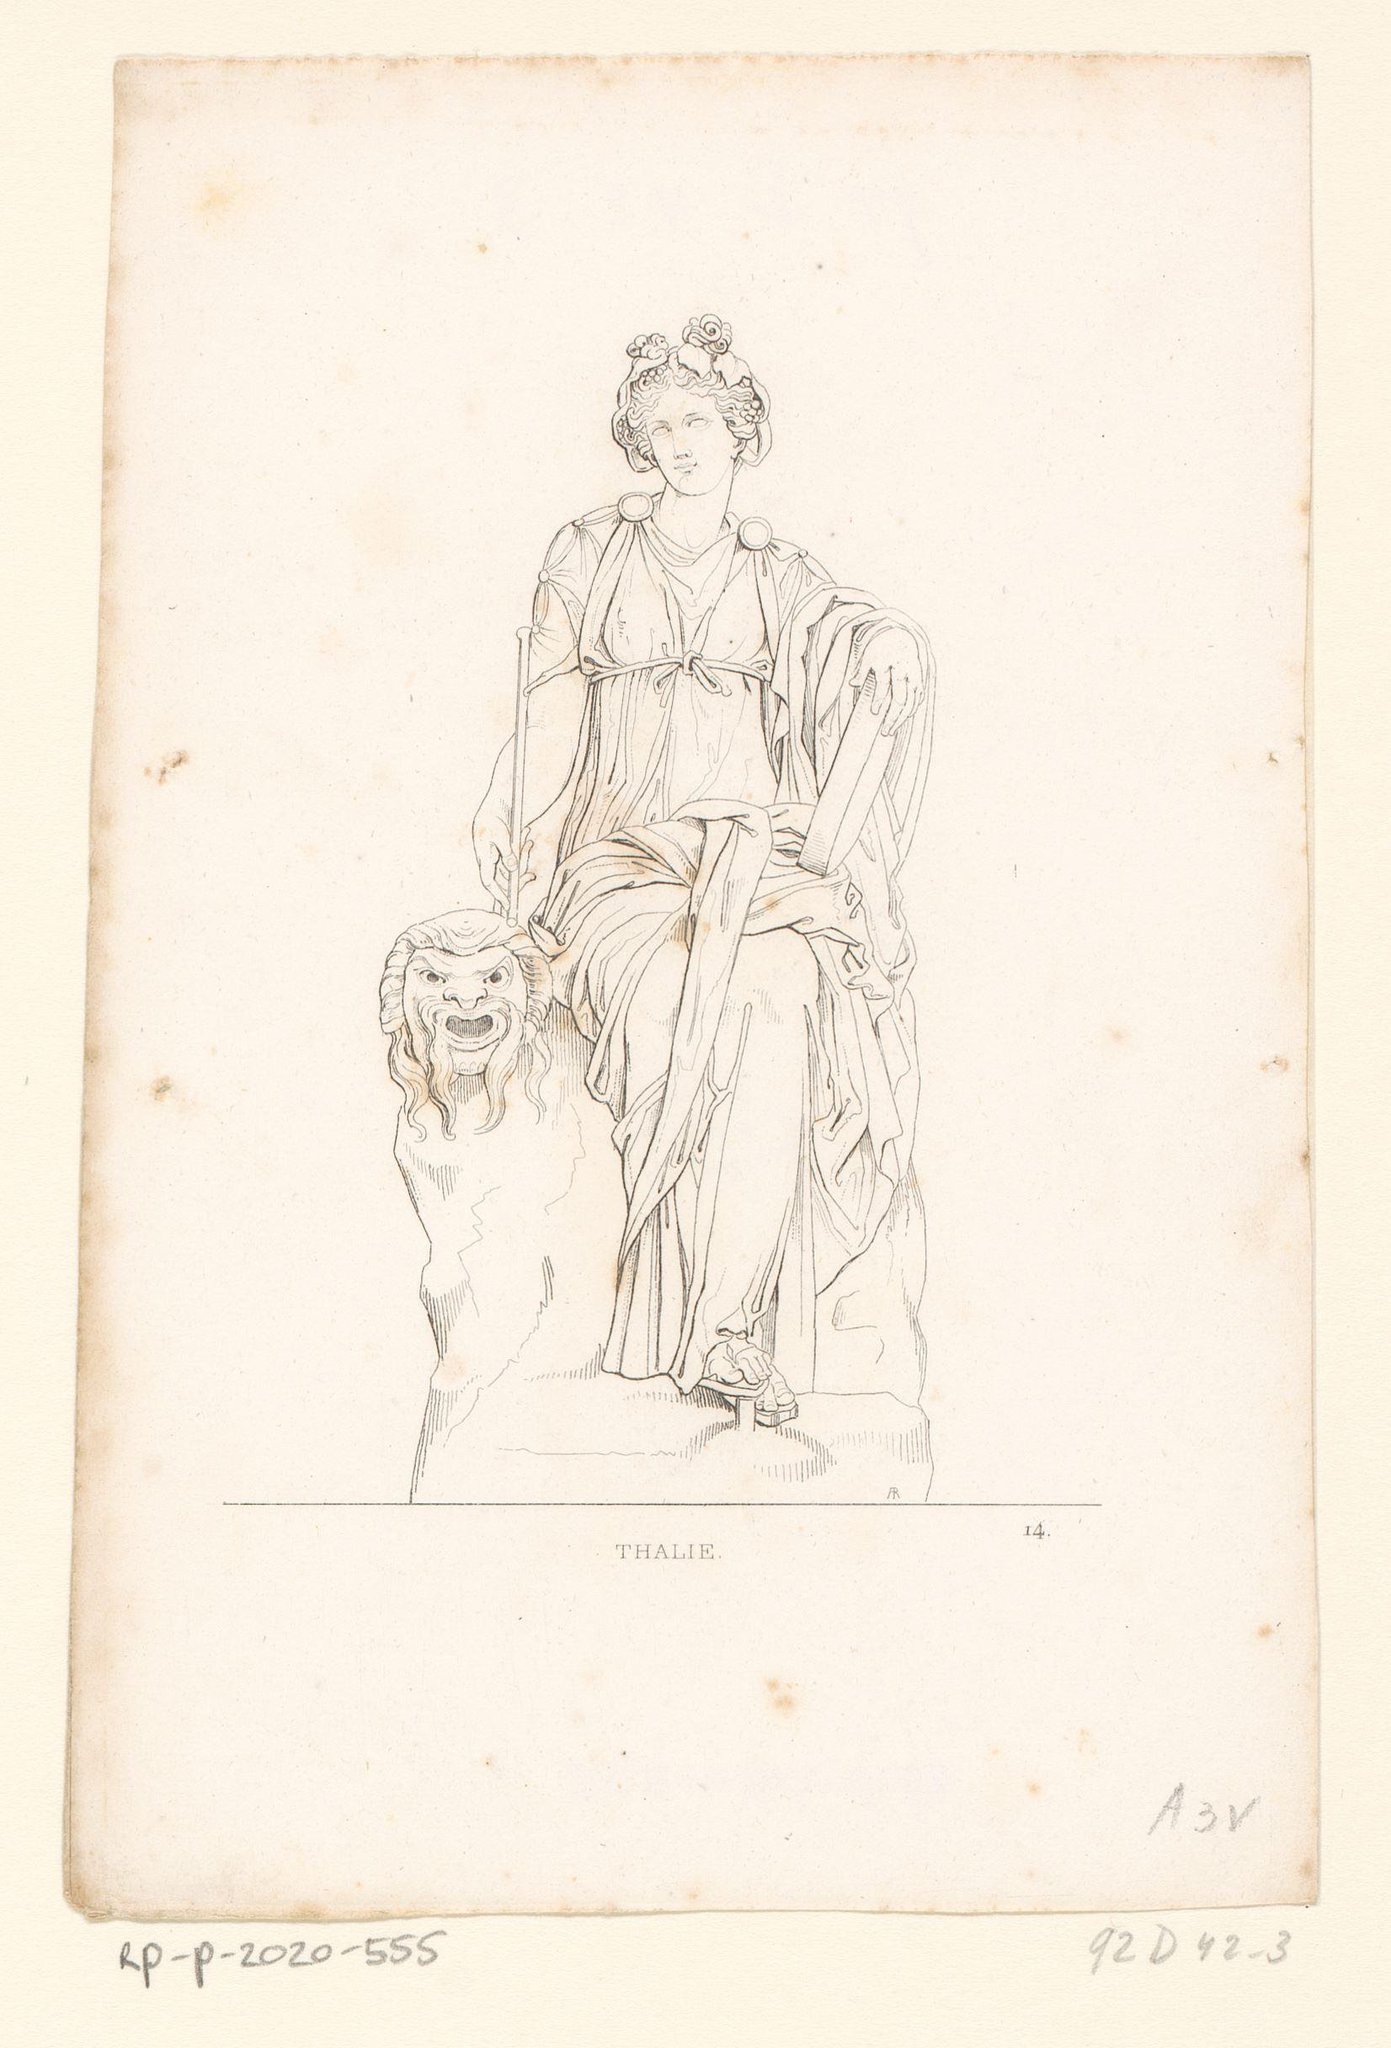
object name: print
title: Thaleia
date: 1829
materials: paper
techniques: etching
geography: france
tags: thalia (one of the muses); 'talia' (ripa)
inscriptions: collector's mark: Lugt 2228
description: Prent ook gebruikt in: Duchesne, Jean. Musée de peinture et de sculpture, ou Recueil des principaux tableaux, statues et bas-reliefs (...). Parijs: Louis-Eustache Audot, 1829, dl. 5.